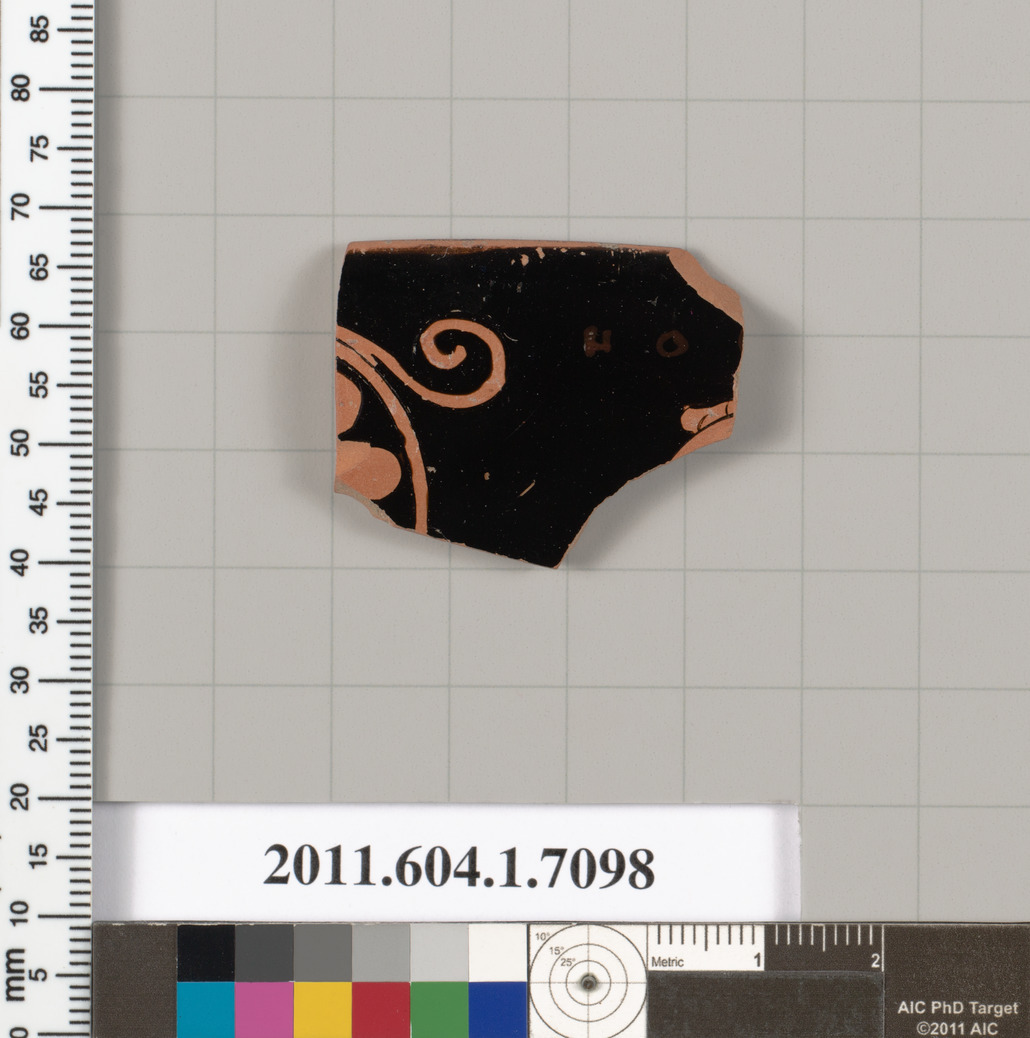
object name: kylix fragment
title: Terracotta fragment of a kylix (drinking cup)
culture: greek, attic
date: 500-480 BCE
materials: terracotta